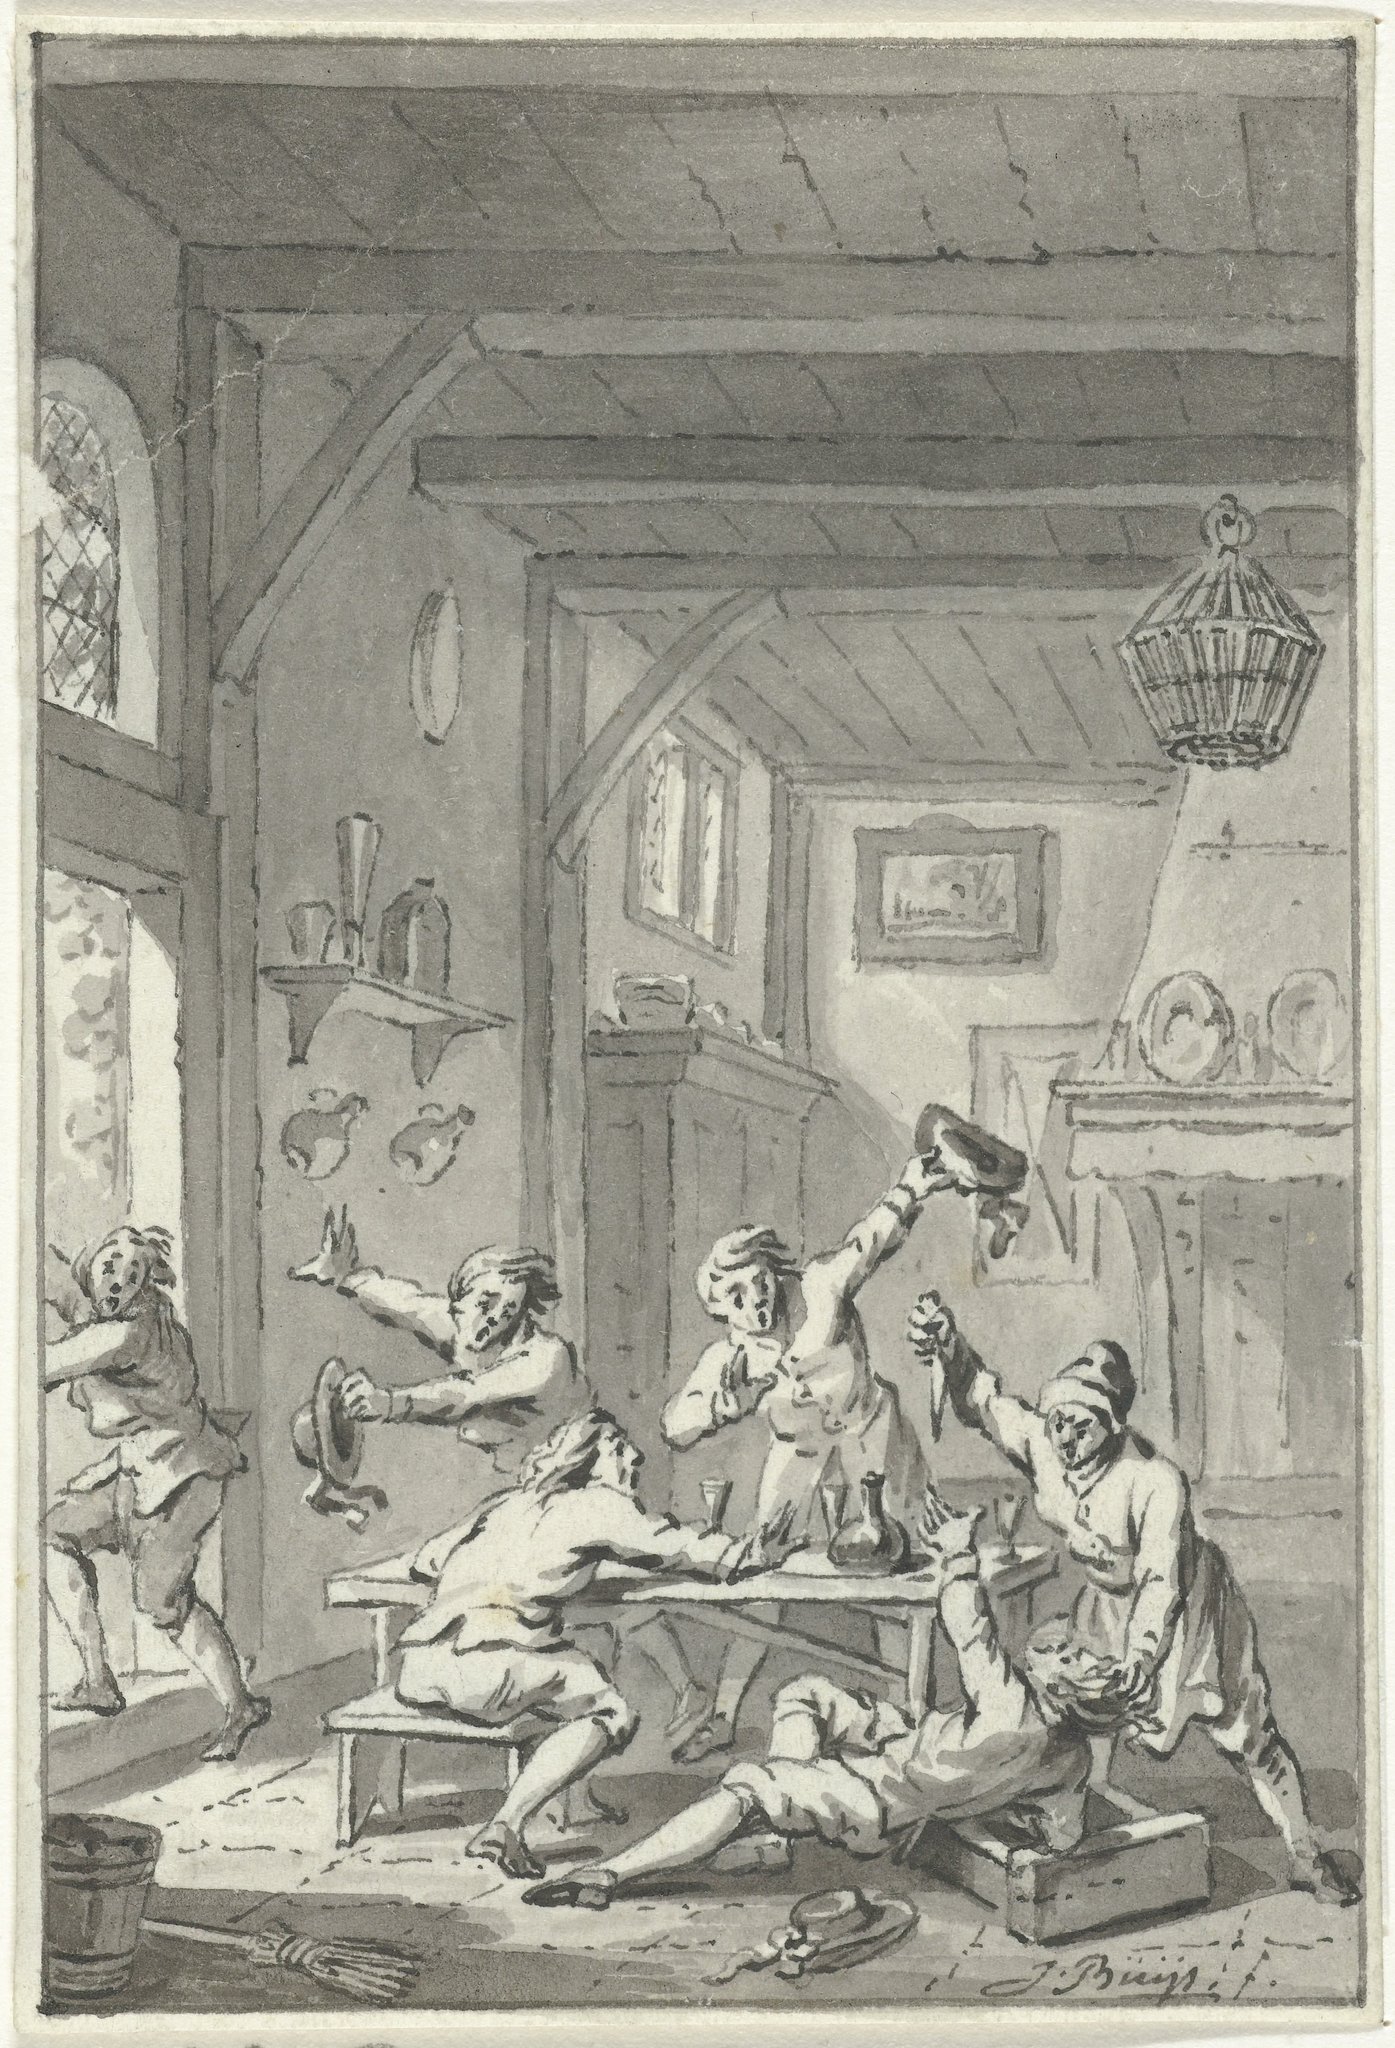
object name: drawing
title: Gevechten met Orangisten te Voorburg, 1787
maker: jacobus buys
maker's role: draughtsman, print maker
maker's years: 1724-1801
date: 1787-1795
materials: ink, paper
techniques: brush, pen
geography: northern netherlands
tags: street-fights, riots, drunken brawl (usually peasants fighting in an inn), fighting, voorburg, patriots (1780-1795)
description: Gevechten met enkele Orangisten in een herberg te Voorburg, 8 oktober 1787. Ontwerp voor een prent.